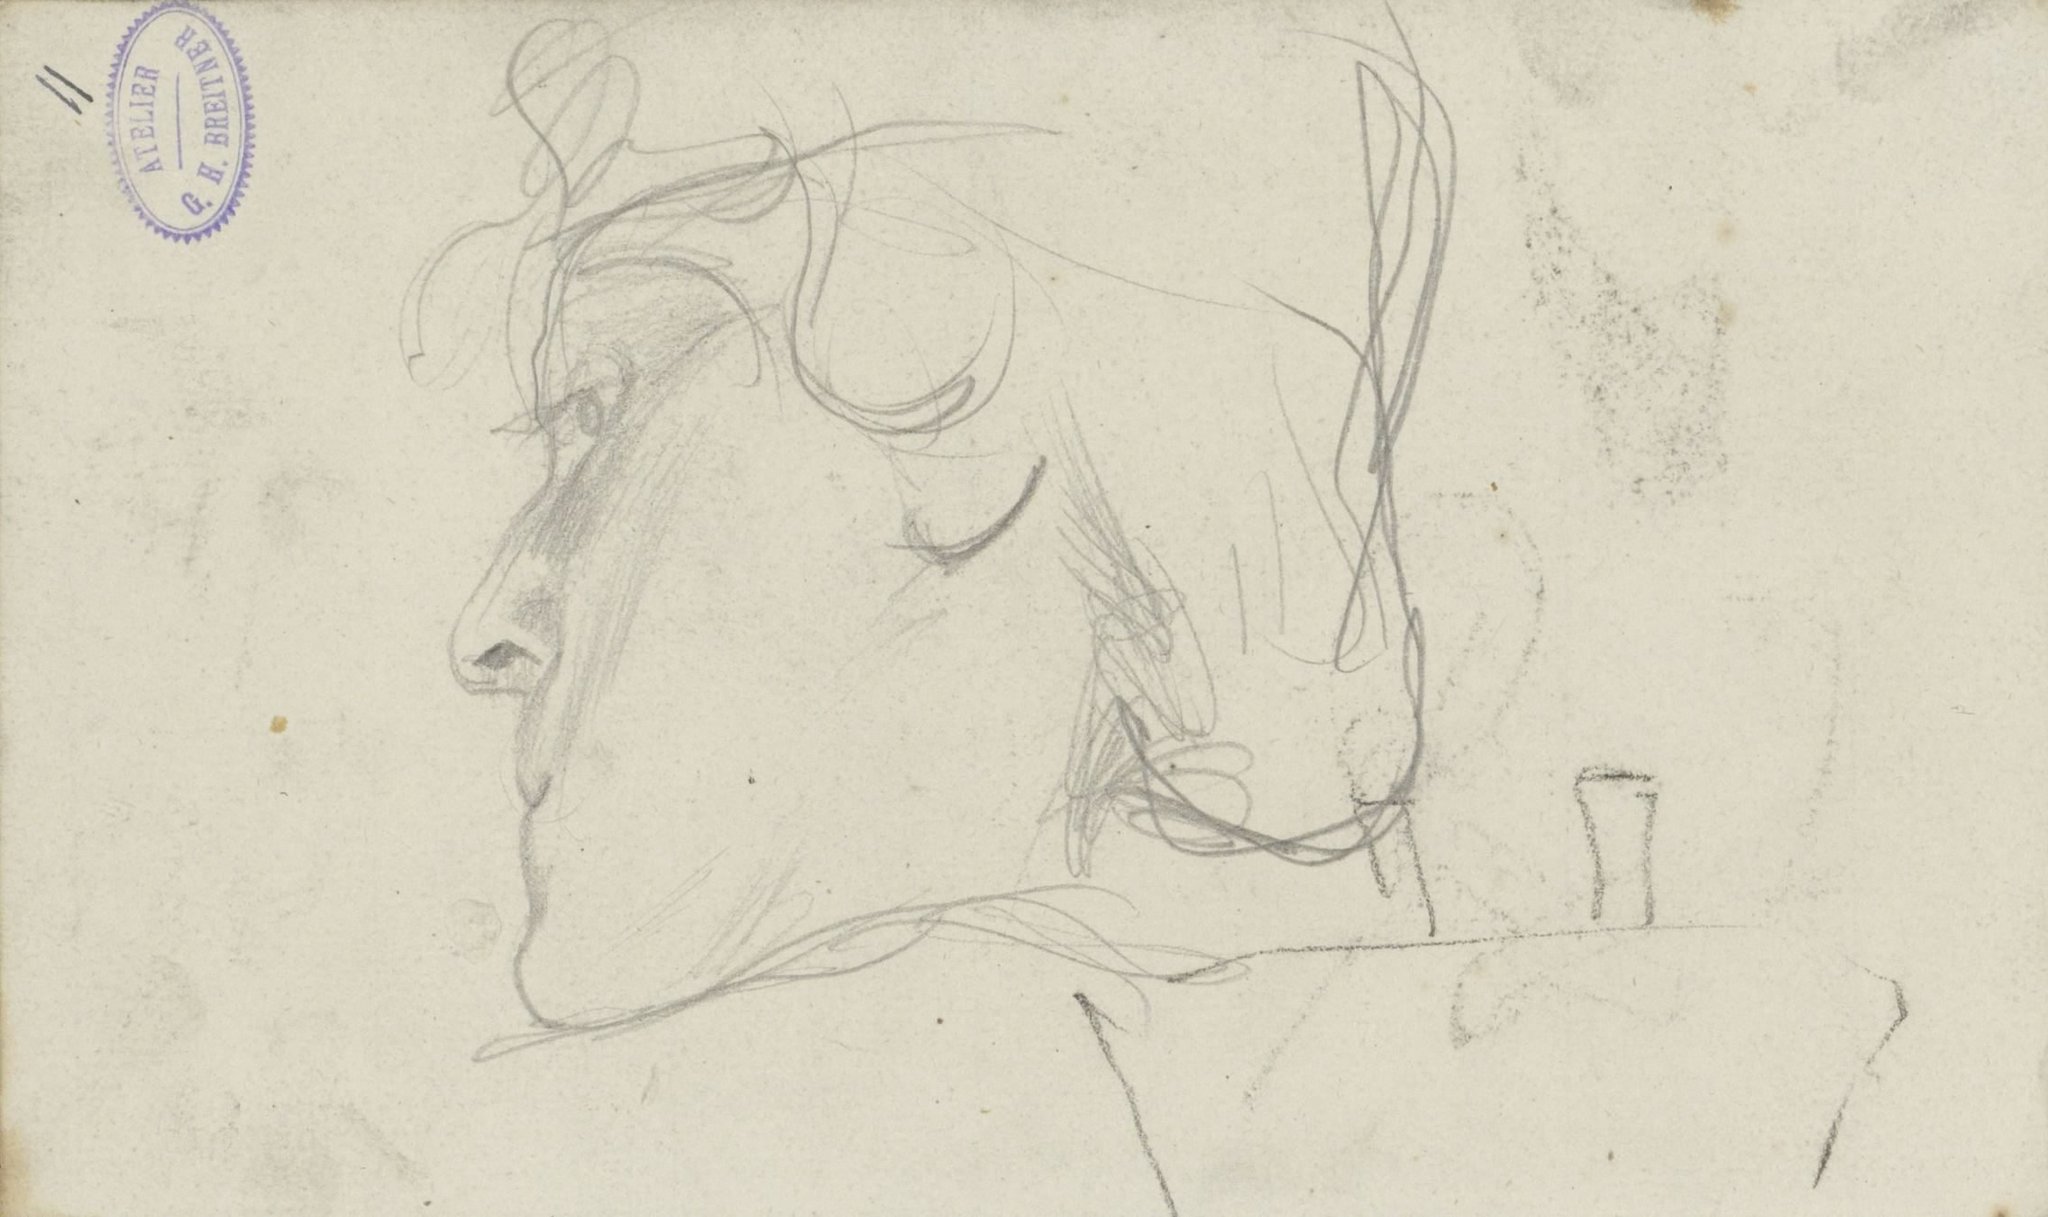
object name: drawing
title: Vrouwenhoofd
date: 1887-1891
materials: chalk, paper, pencil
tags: head (human) - aa - female human figure (+ sideview, profile)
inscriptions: collector's mark: Lugt 2228, workshop stamp: Lugt 291d